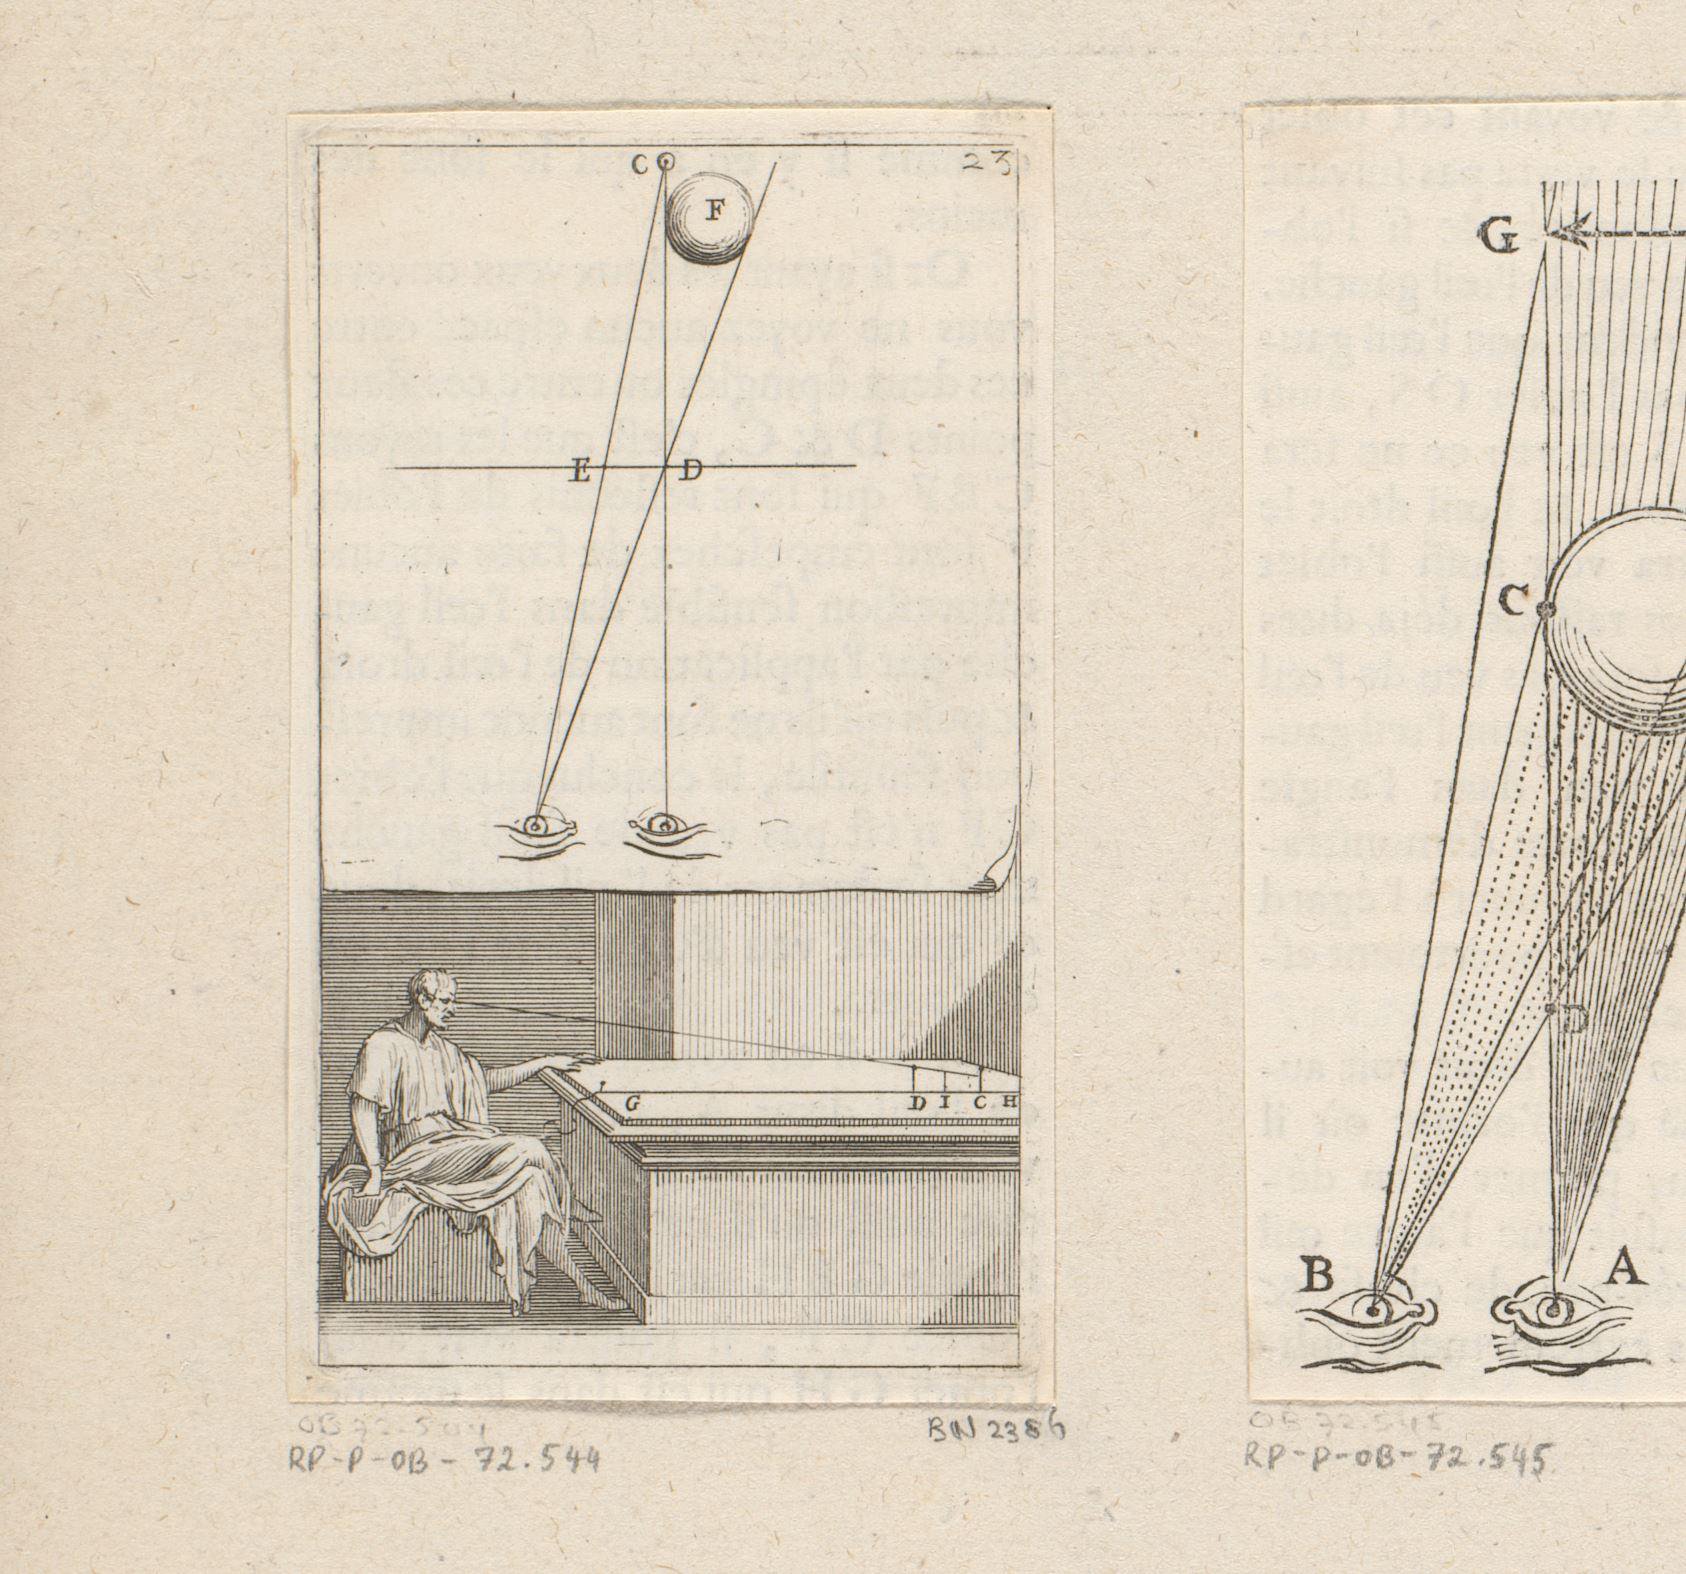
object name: book illustration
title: Gezichtsveld van een man aan een tafel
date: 1679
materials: paper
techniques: engraving, etching, letterpress printing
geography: france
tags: optics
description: Prent uit: Leclerc, Sébastien. Discours touchant le point de veue, dans lequel il est prouvé que les choses qu'on voit (...). Parijs: Thomas Jolly, 1679.